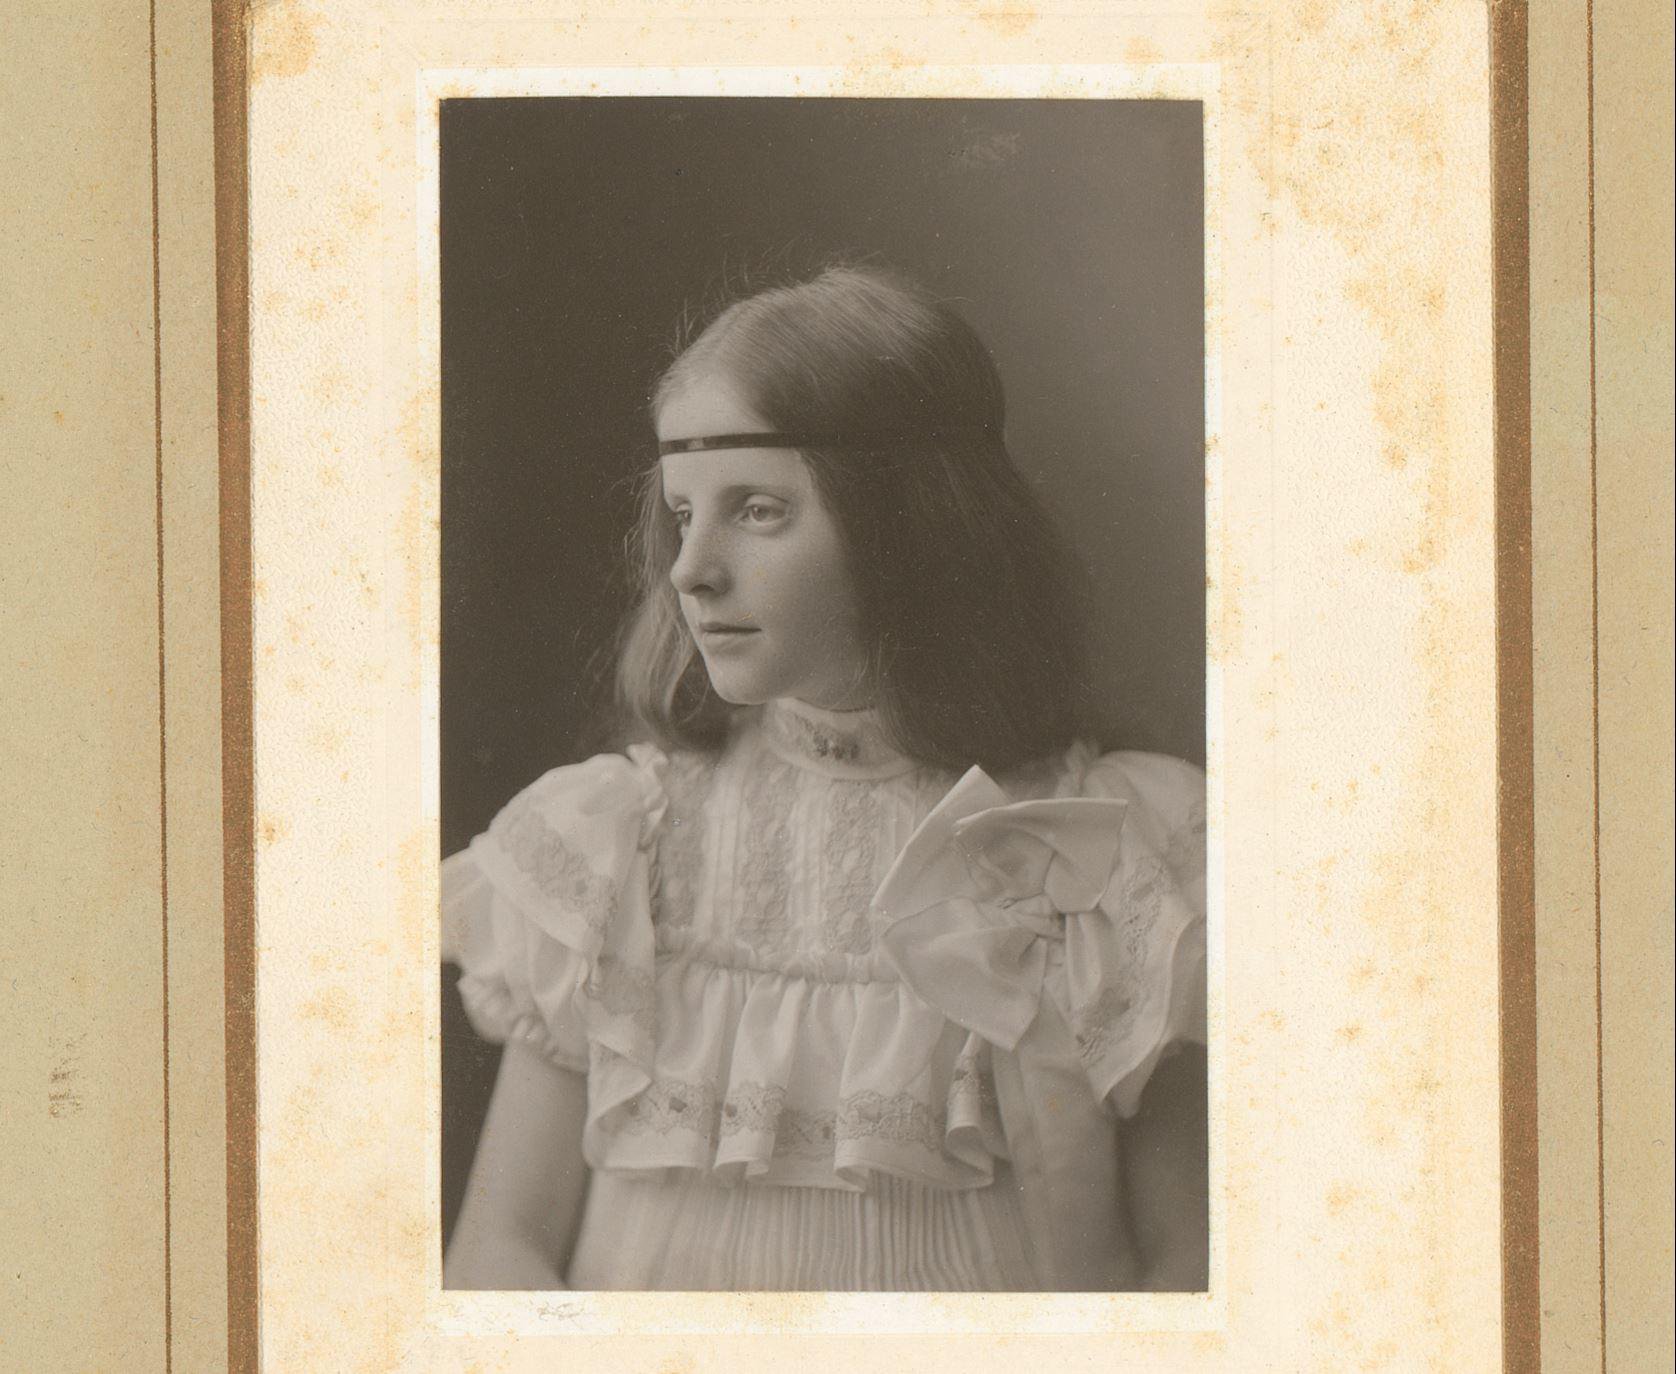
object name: photograph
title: Portret van een meisje in witte strokenjurk met hoofdband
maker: albert greiner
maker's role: fotograaf, fotostudio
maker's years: 1833-1890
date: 1880-1887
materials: cardboard, photographic support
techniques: collodion silver print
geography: amsterdam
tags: girl (child between toddler and youth)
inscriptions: inscription: ‘A. Greiner/ Nieuwendijk 89/ Amsterdam’